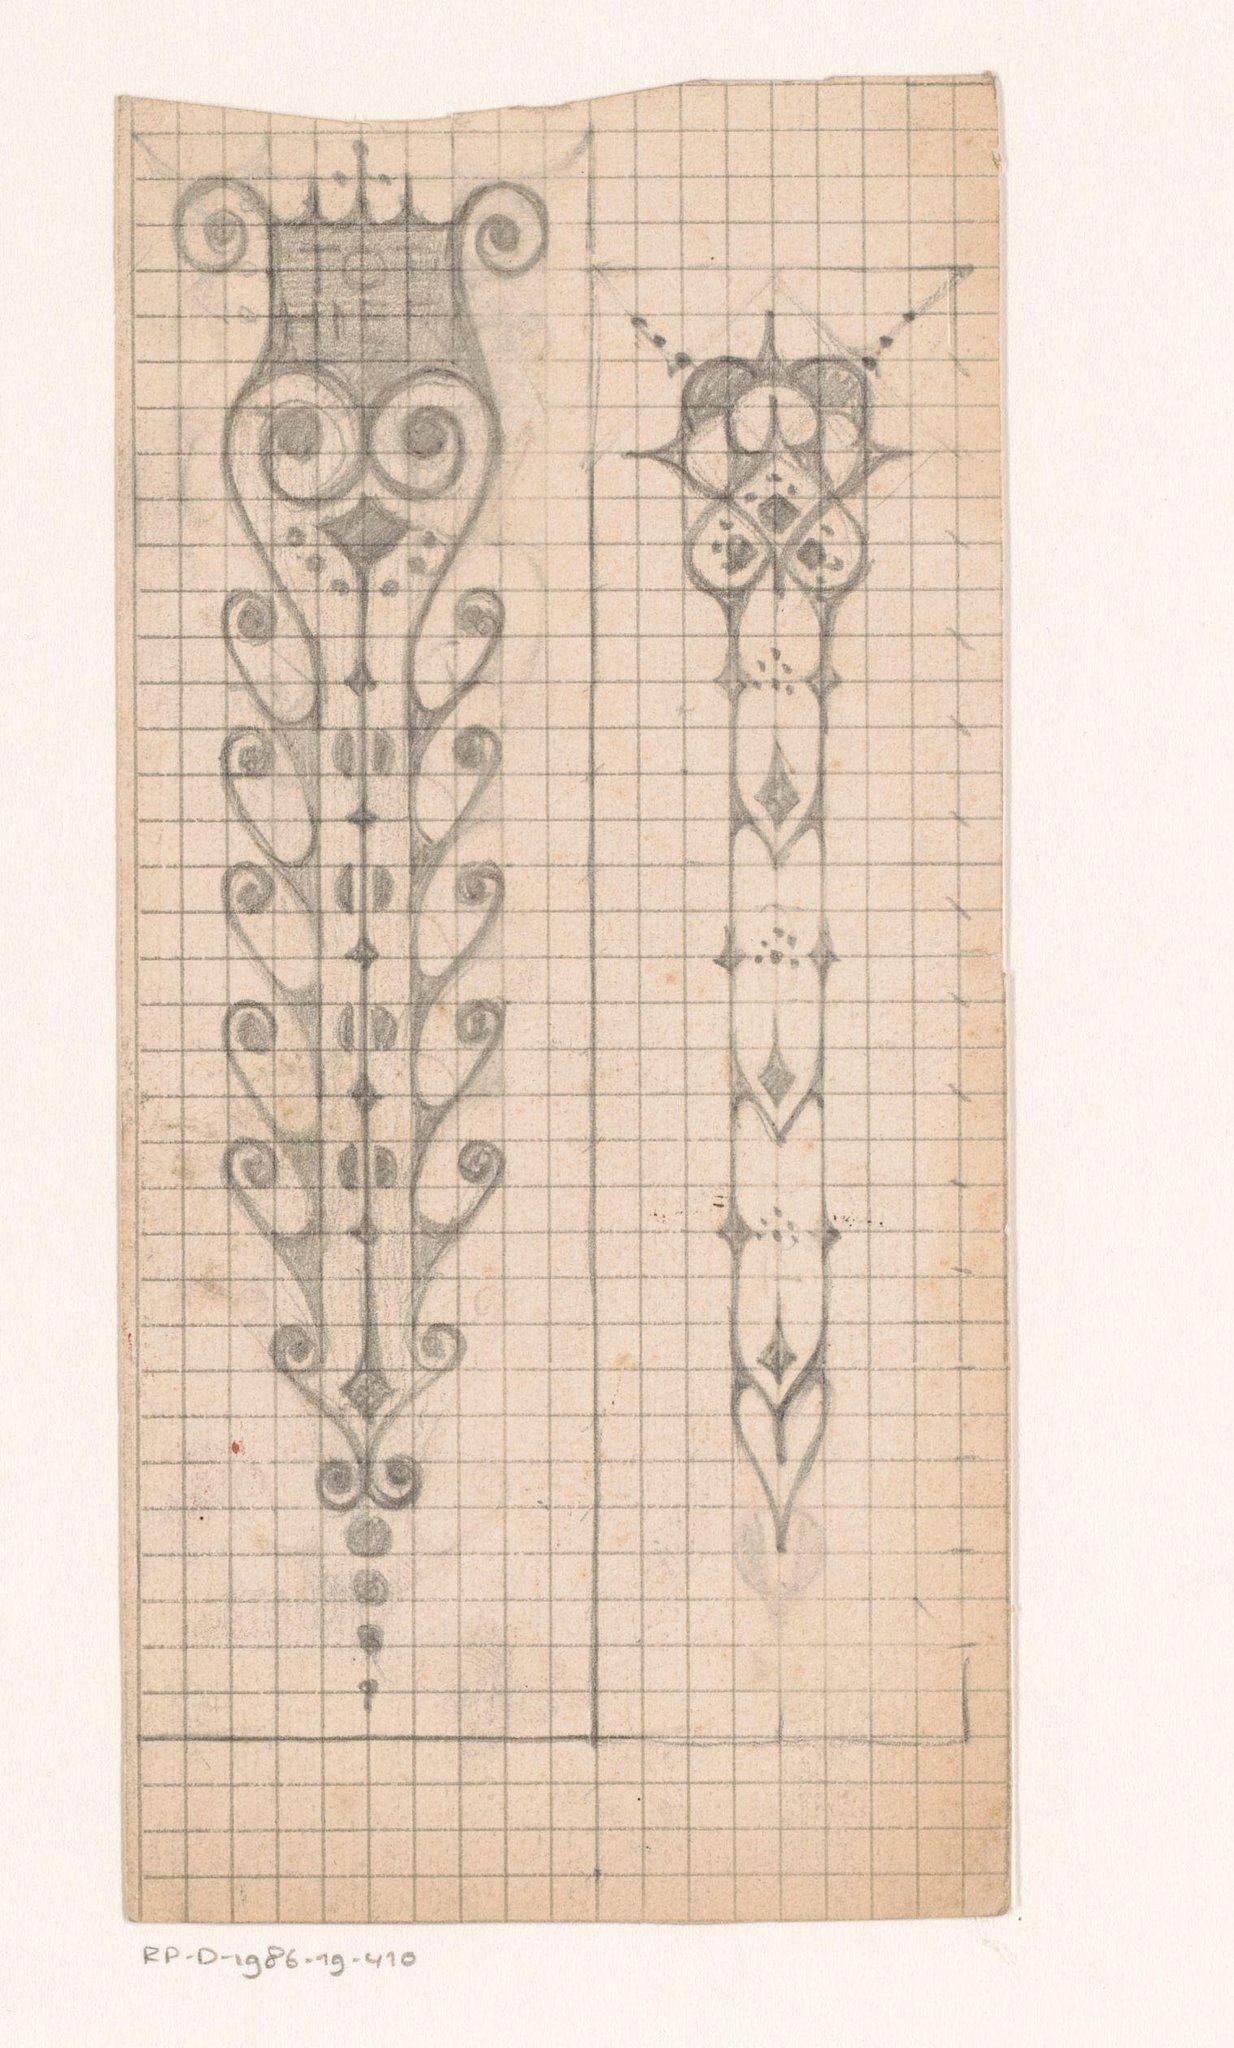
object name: drawing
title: Ornamenten met krullende vormen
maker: reinier willem petrus de vries (1874-1953)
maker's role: draughtsman, print maker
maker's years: 1874-1953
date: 1884-1952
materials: pencil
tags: ornament ~ spiral and derived from spiral, e.g.: greek wave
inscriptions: collector's mark: ‘R:MVS.’